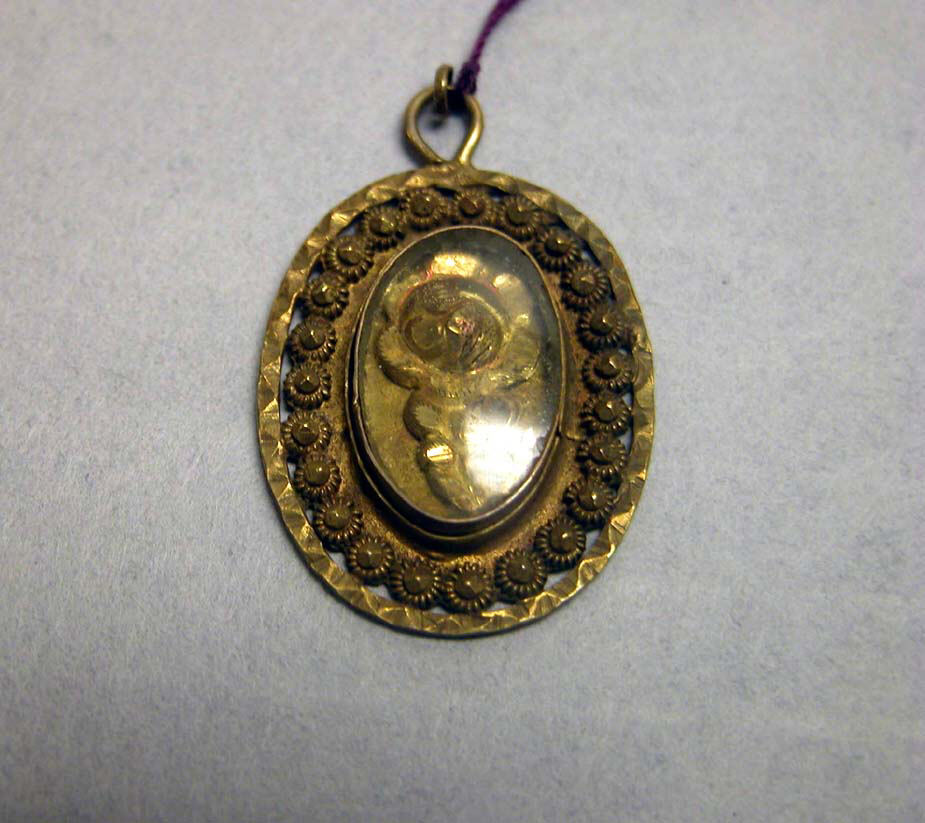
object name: pendant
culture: filipino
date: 1601-1900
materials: gold